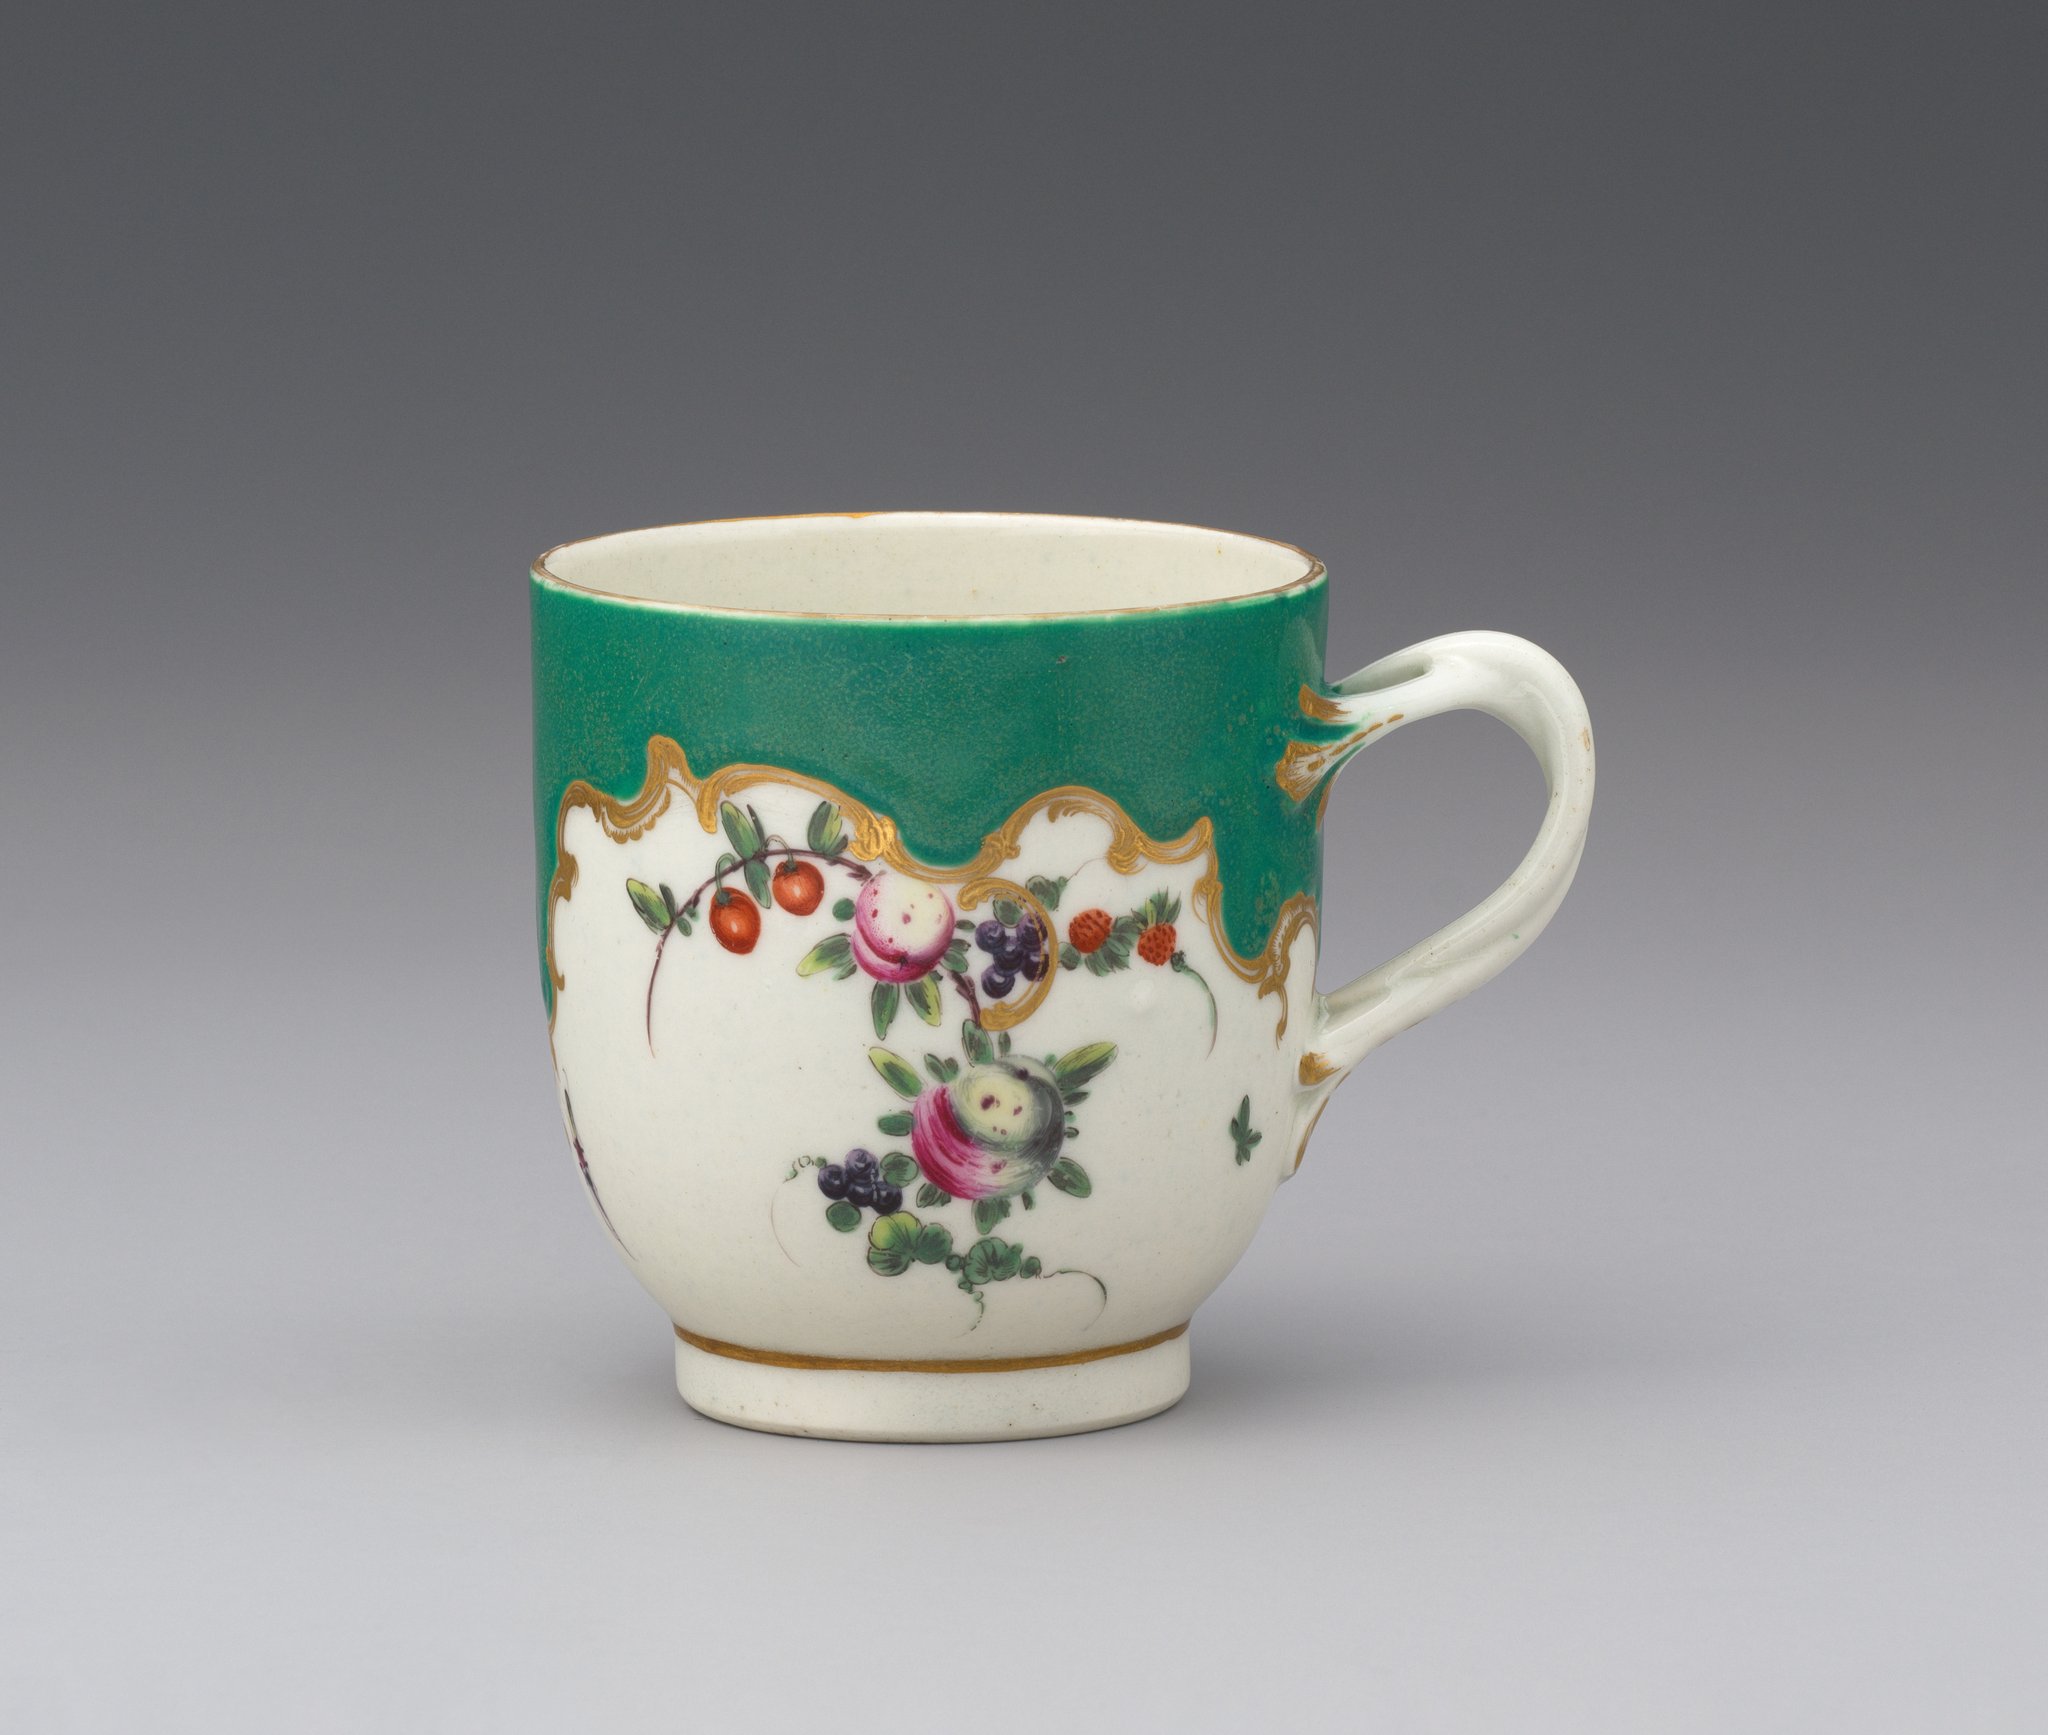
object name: cup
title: Cup (part of a service)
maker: worcester factory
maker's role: factory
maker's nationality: british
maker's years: 1751-2008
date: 1770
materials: soft paste porcelain